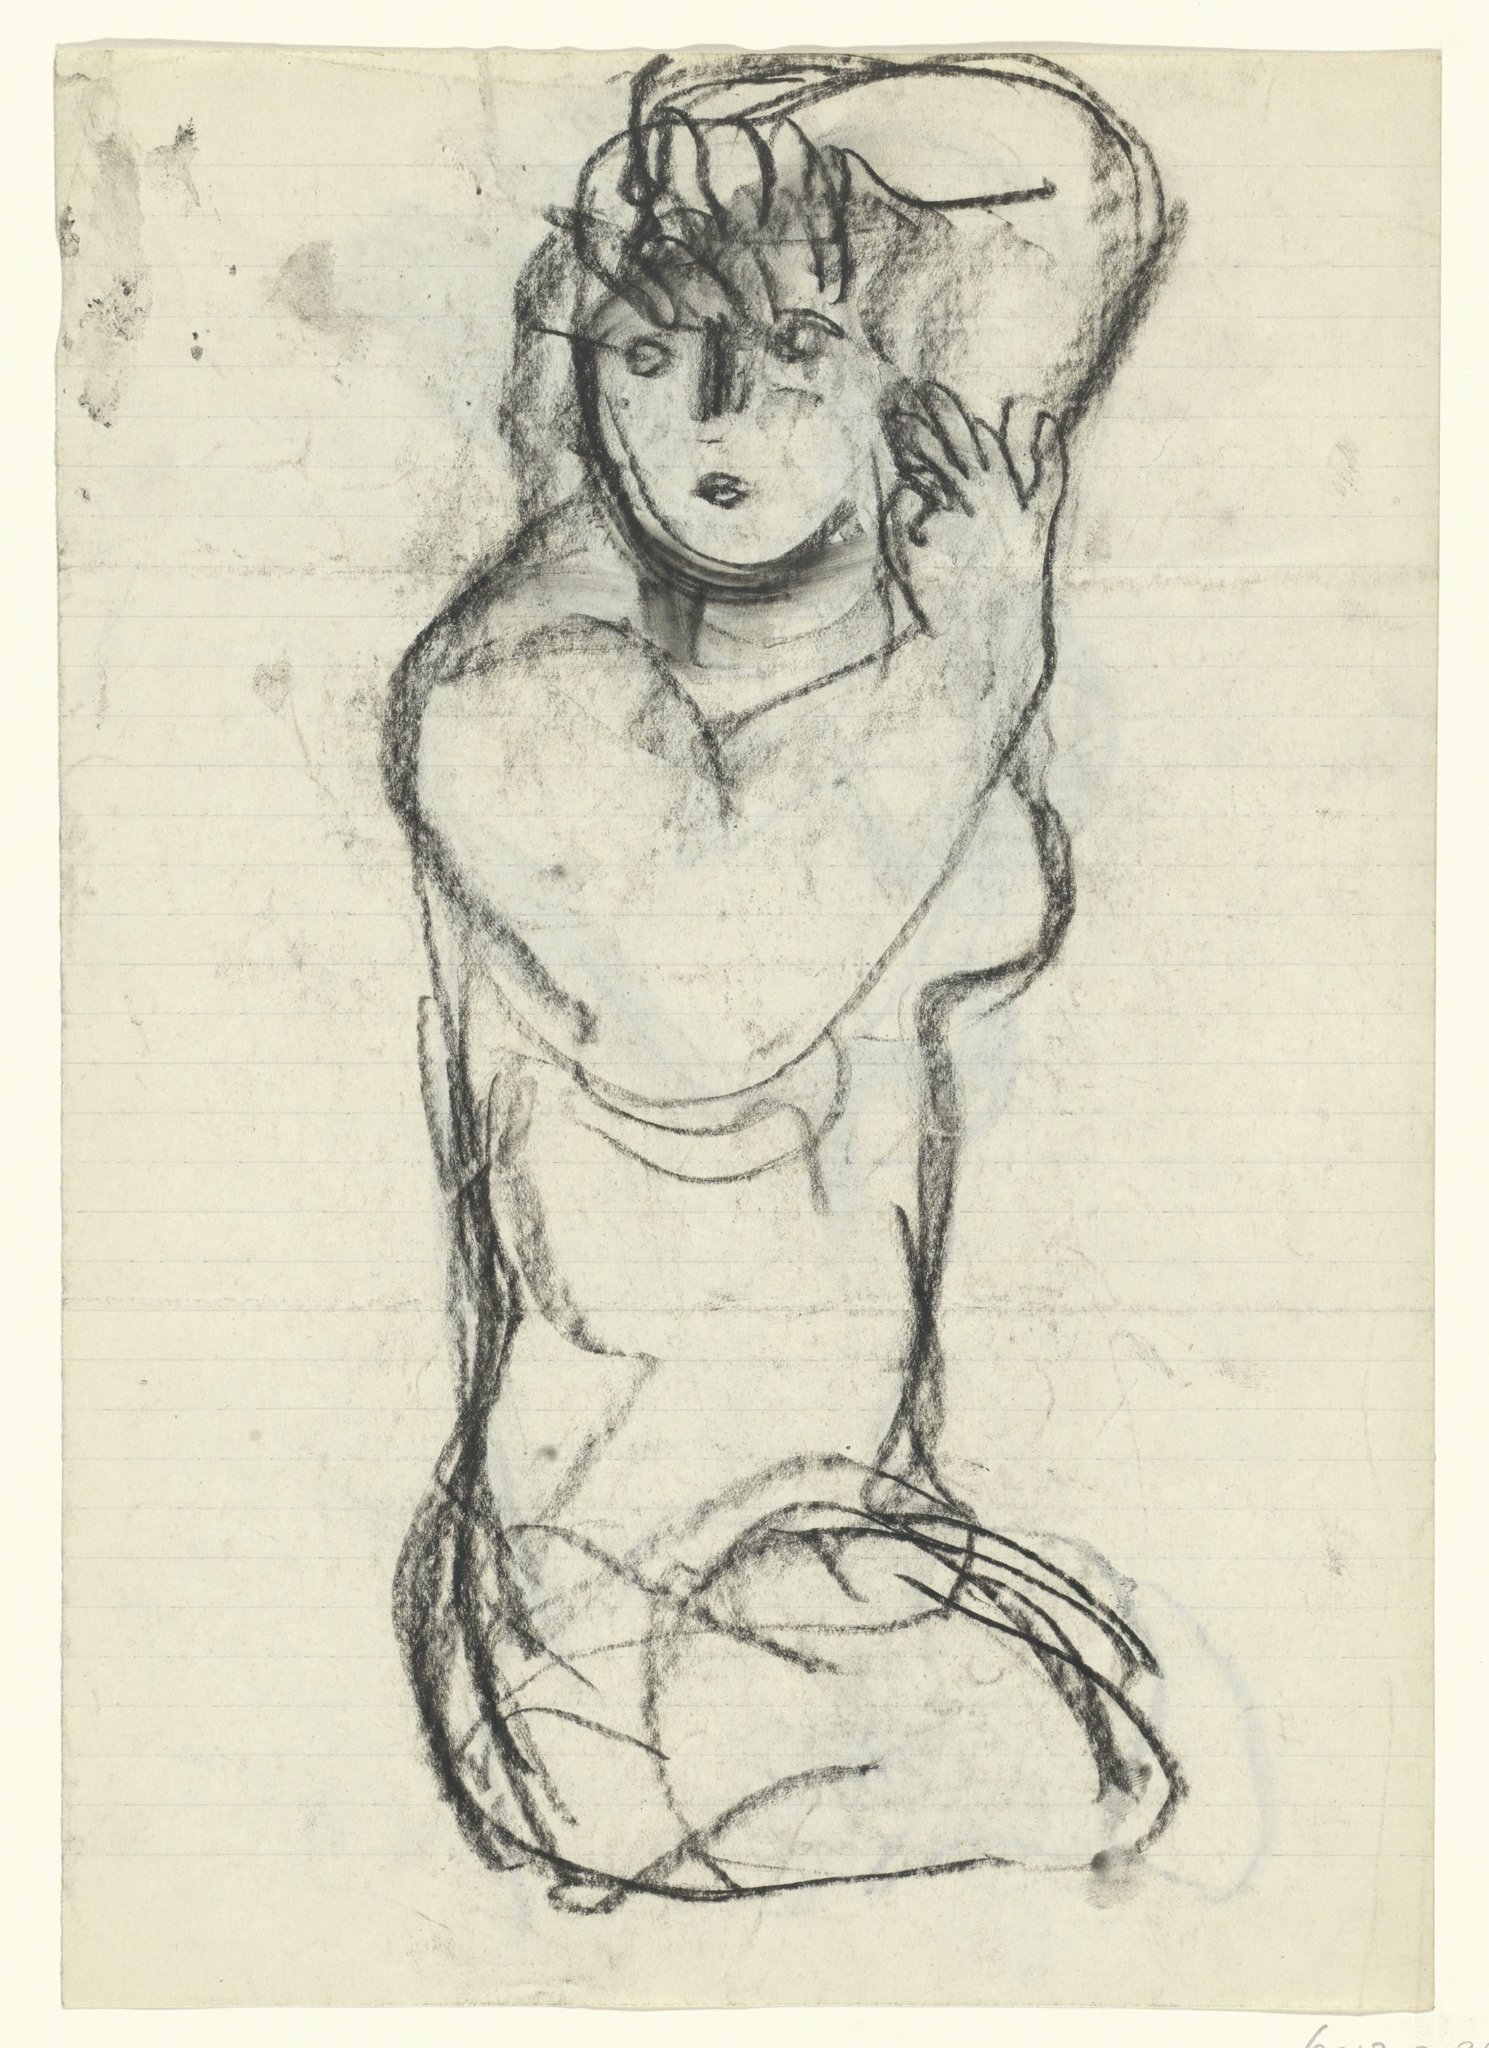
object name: drawing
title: Geknielde naakte vrouw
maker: leo gestel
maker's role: draughtsman, print maker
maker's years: 1881-1941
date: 1891-1941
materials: chalk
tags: female sex; woman (+ nude human being)